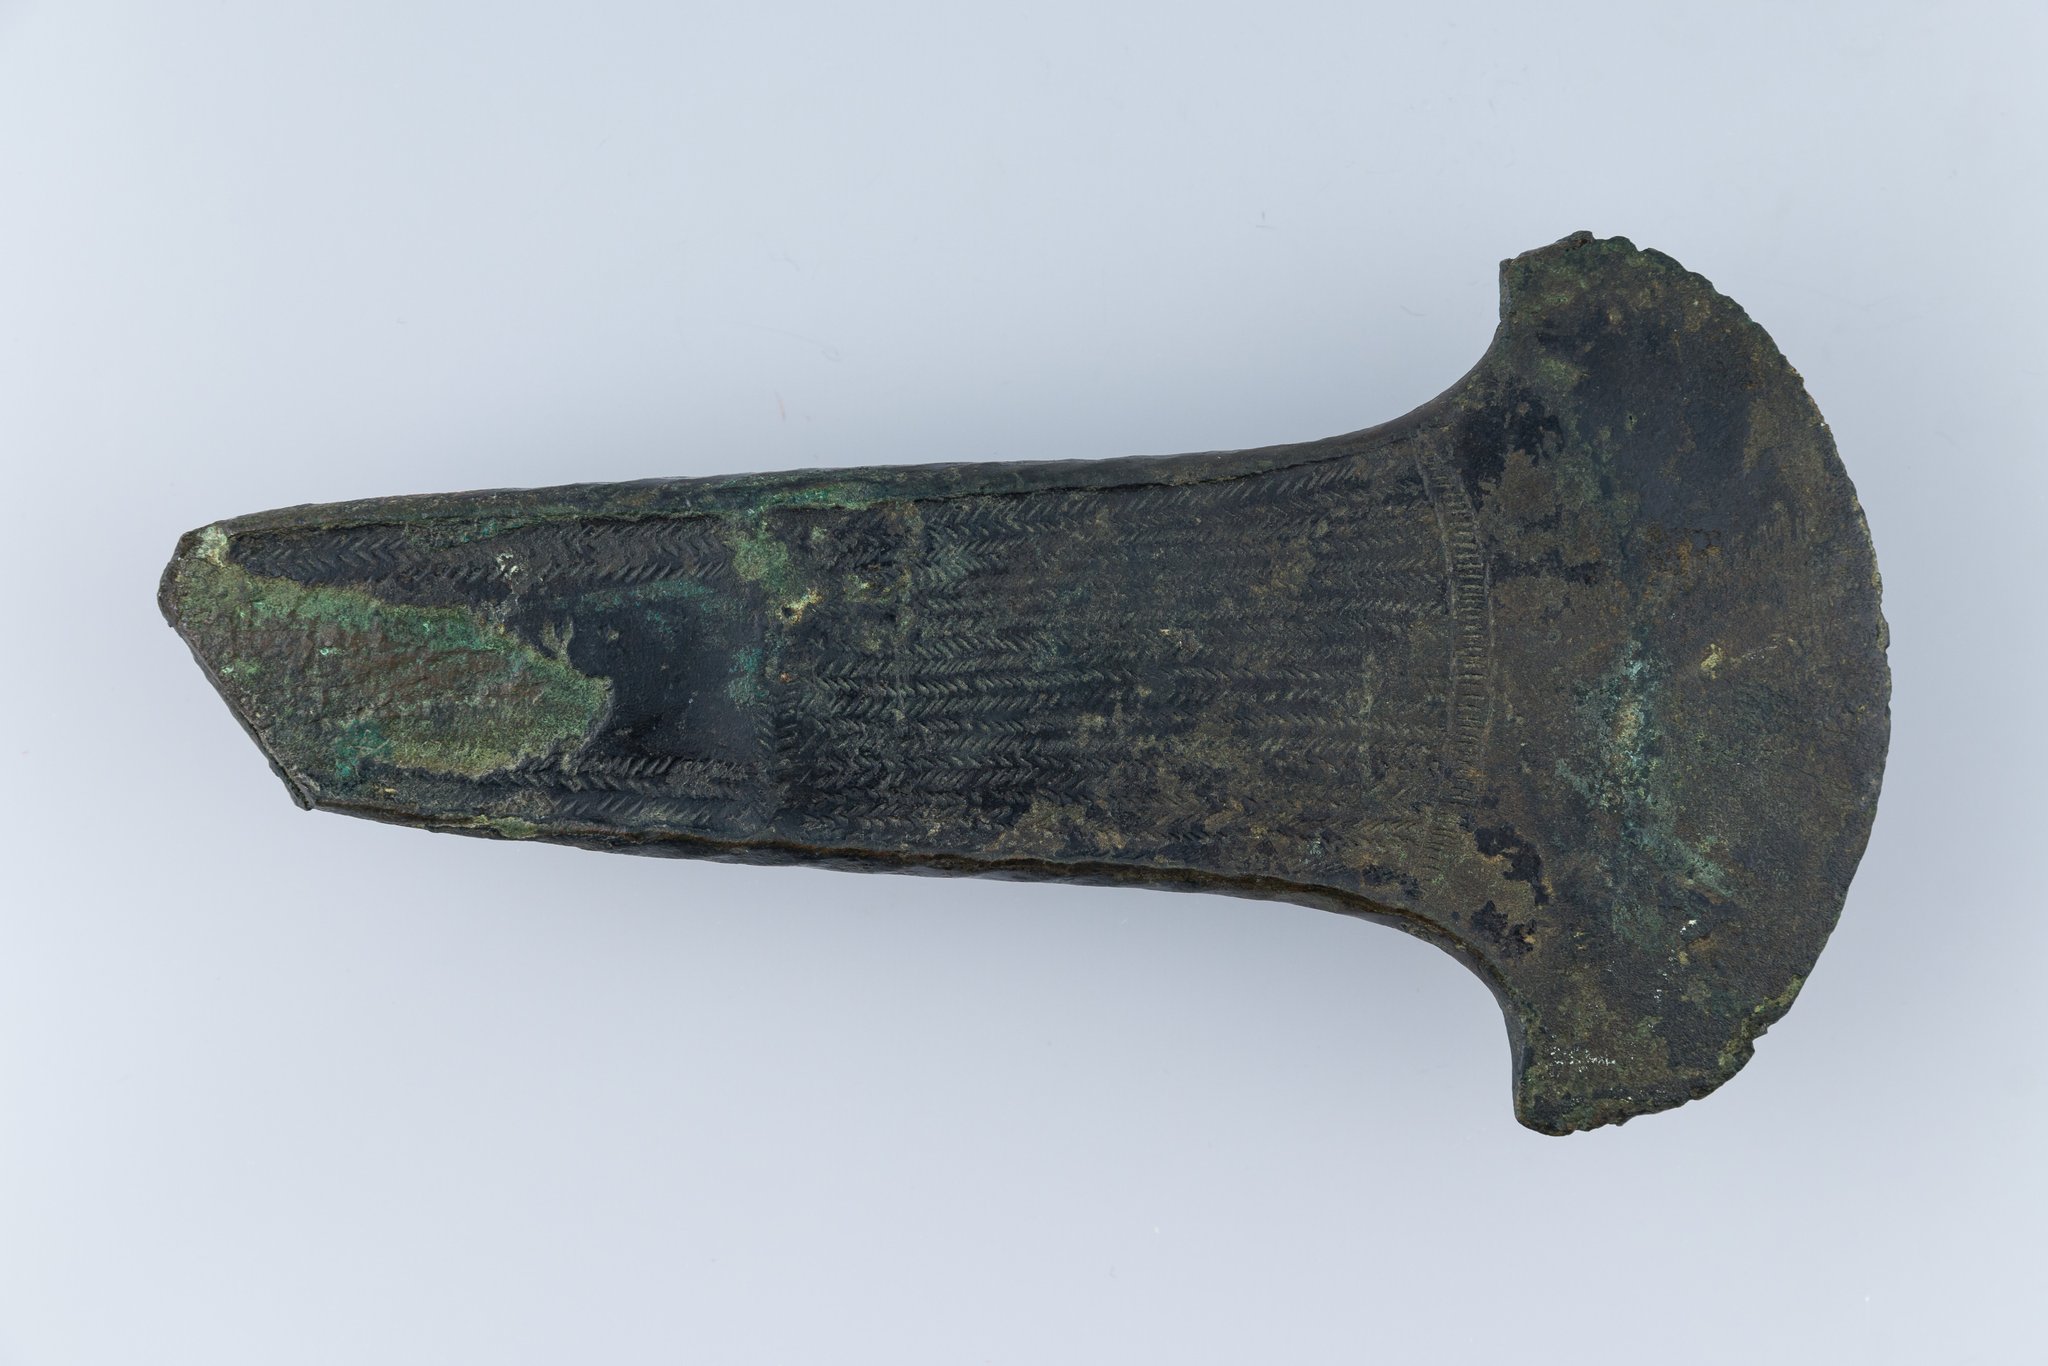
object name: flanged ax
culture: irish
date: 1500-1400 BCE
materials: bronze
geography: ireland